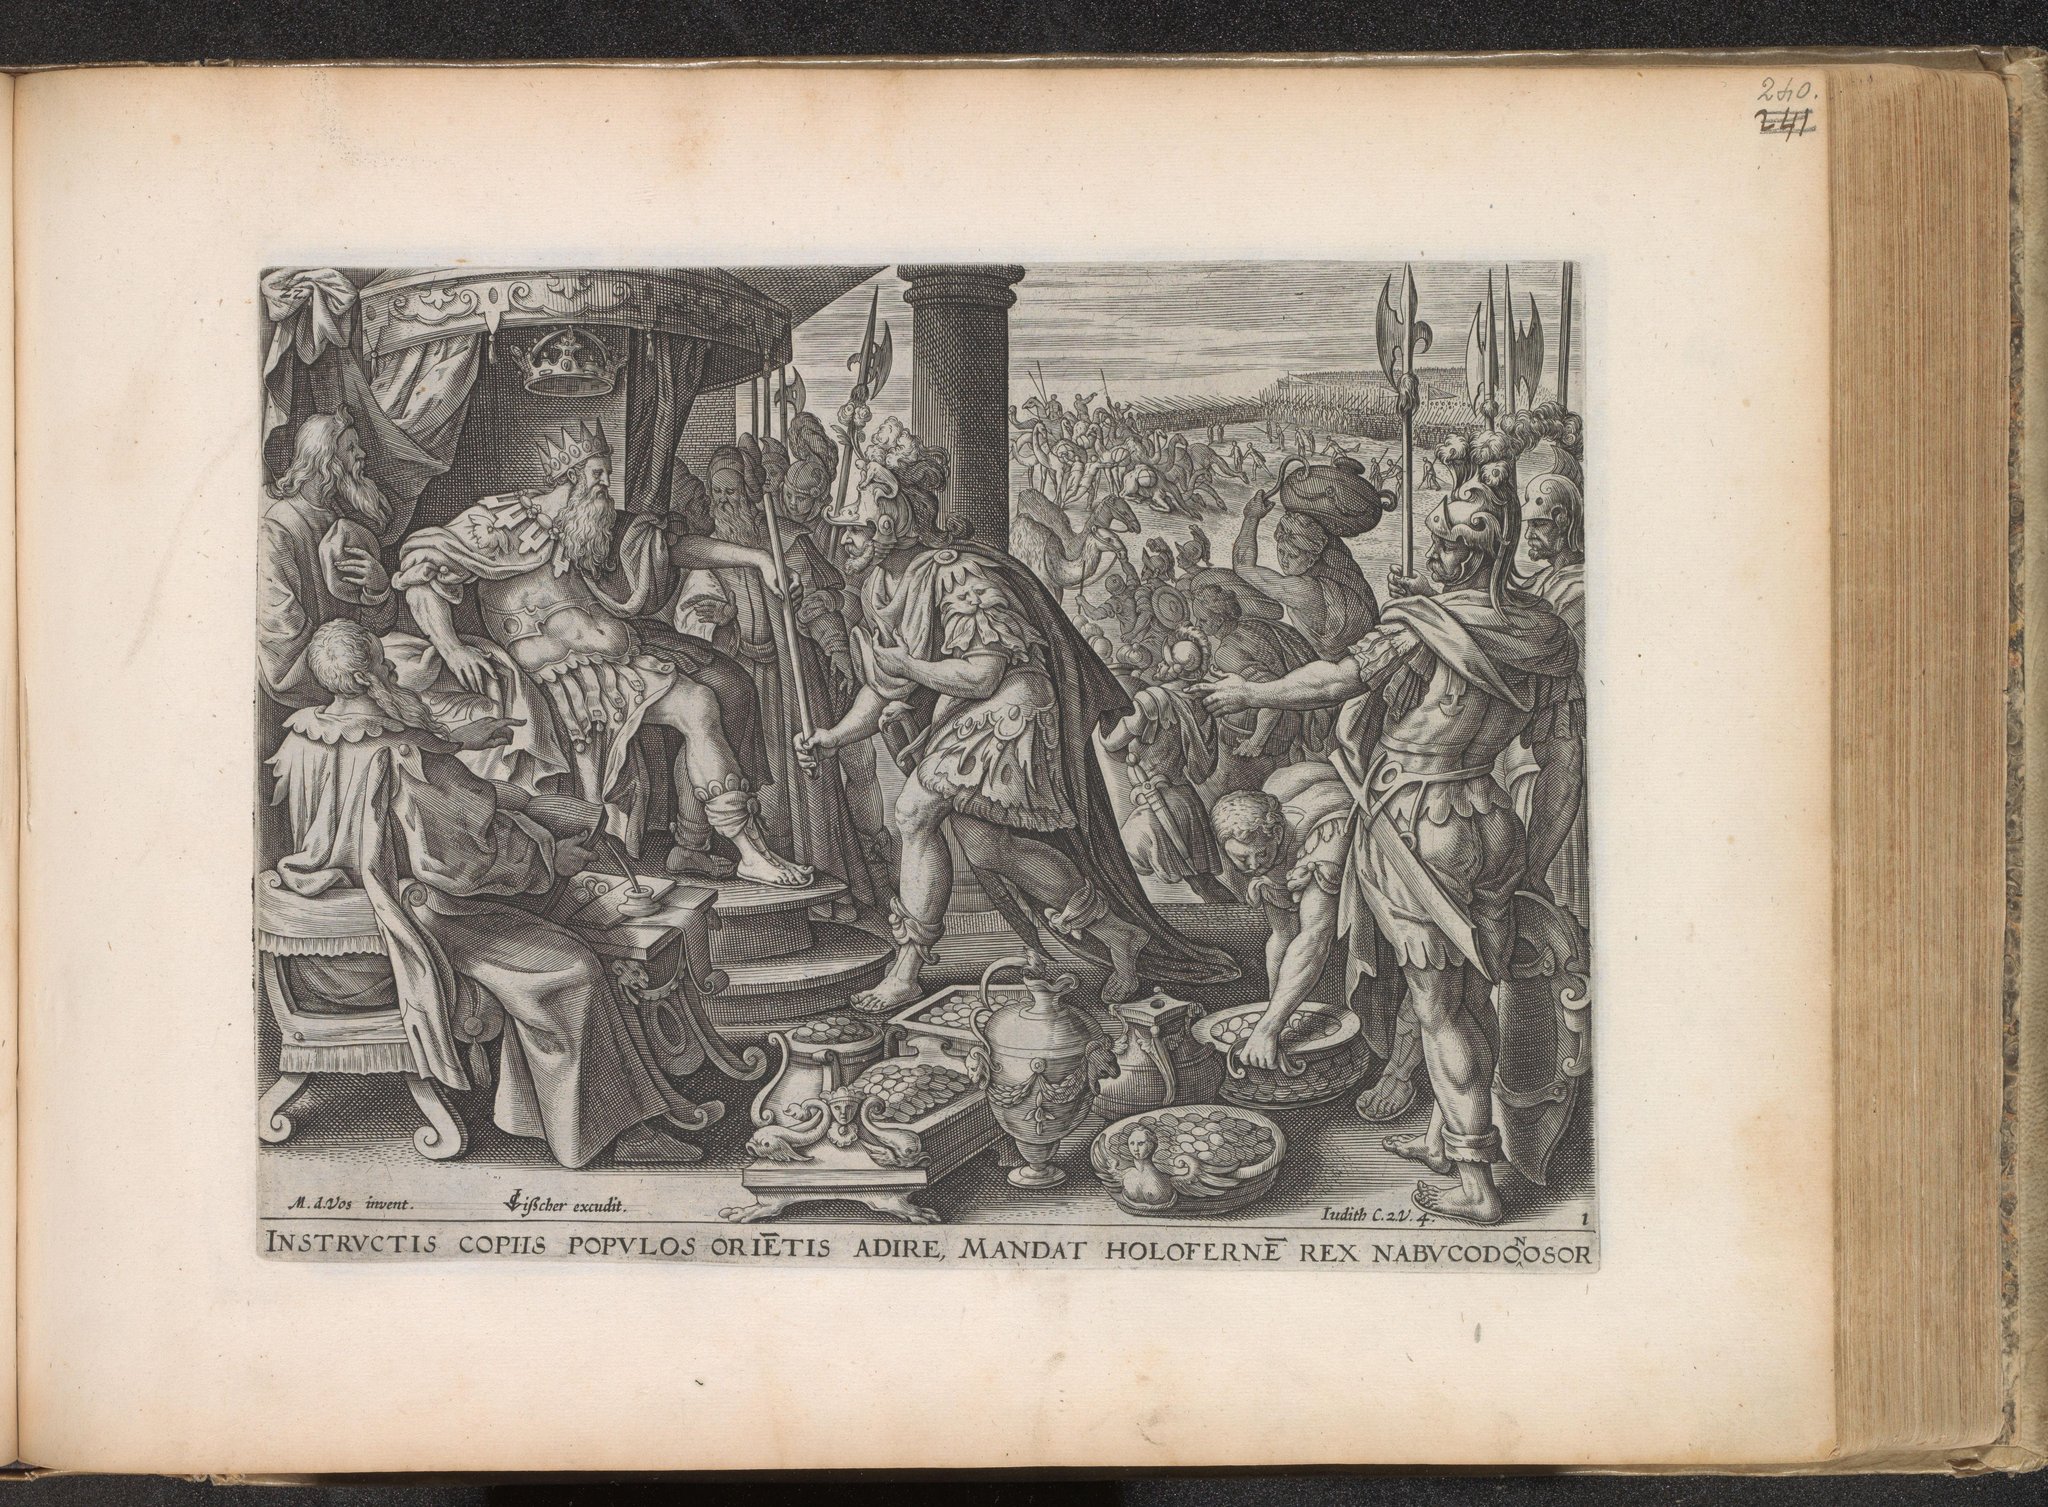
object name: print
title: Geschiedenis van Judit en Holofernes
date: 1585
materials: paper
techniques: engraving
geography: amsterdam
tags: nebuchadnezzar gives holofernes the command of an army to fight the neigbouring states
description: De koning van de Assyriërs Nebukadnessar zit op een troon en ontbiedt zijn opperbevelhebber Holofernes. Hij geeft hem de opdracht ten strijde te trekken tegen de buurvolkeren. Onder de voorstelling een verwijzing in het Latijn naar de Bijbeltekst in Judit 2:4. Deze prent maakt deel uit van een album.